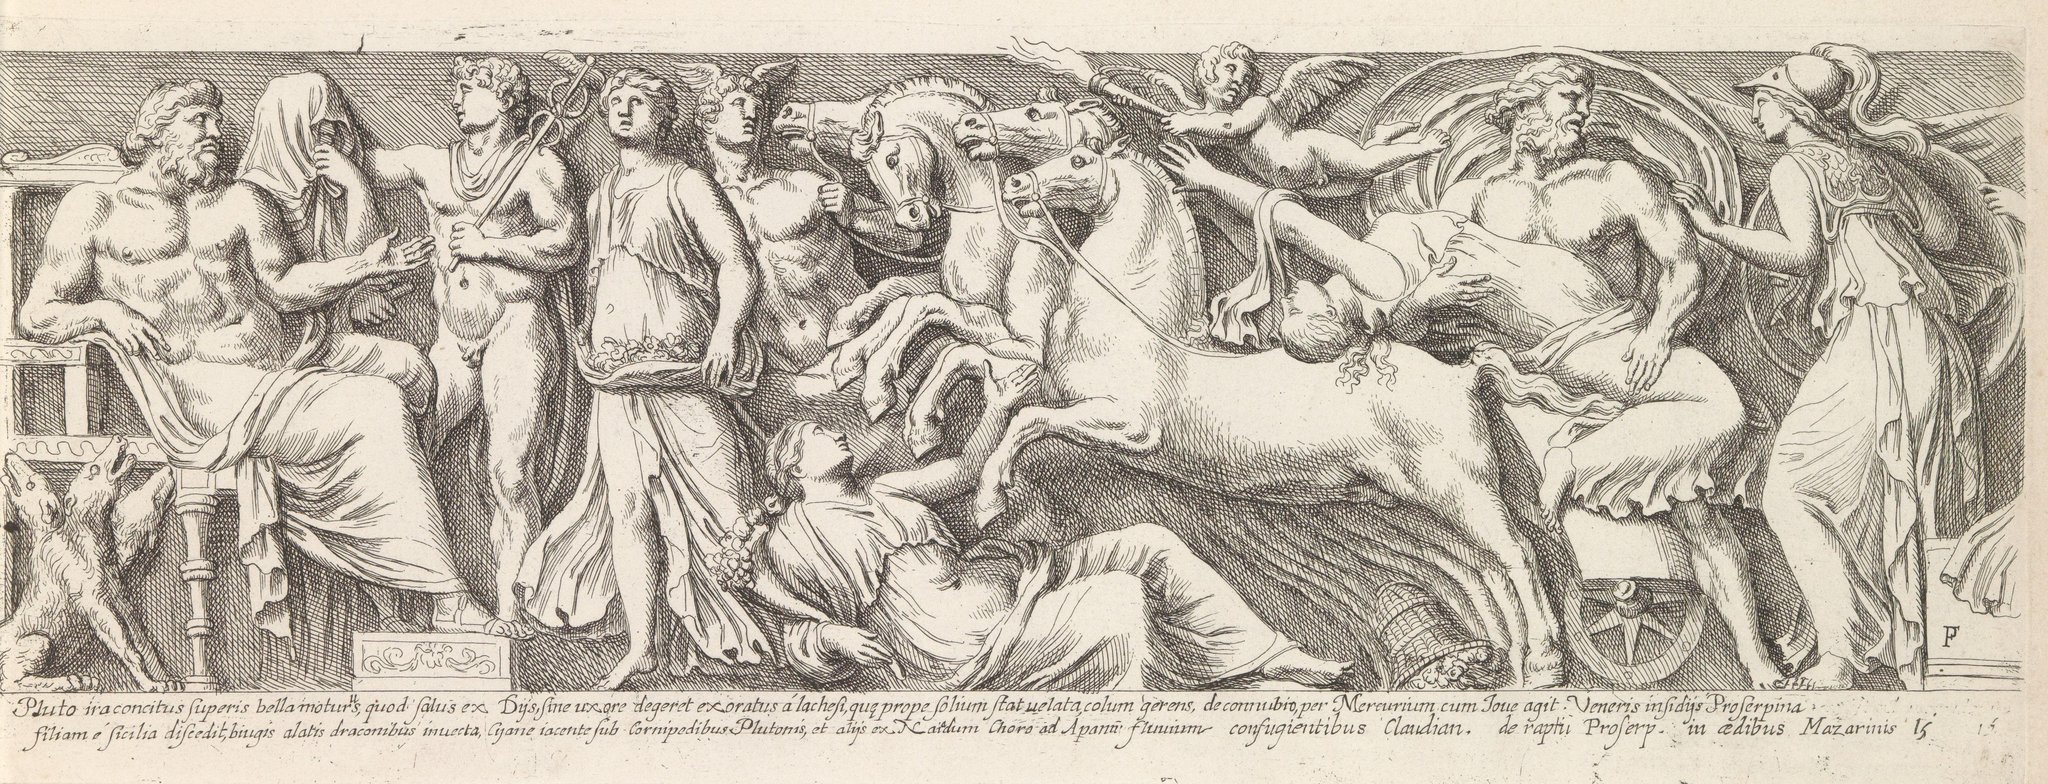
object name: album leaf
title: Reliëf met de roof van Proserpina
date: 1645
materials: paper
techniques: etching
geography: paris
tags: the rape of proserpina (by pluto in his chariot); possibly with diana and minerva trying to rescue her, piece of sculpture, reproduction of a piece of sculpture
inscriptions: number: ‘42’, inscription: ‘Ende lib. No. 5. fol. 105./ Ende lib. No. 5. fol. 78. 79.’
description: Reliëf met de roof van Proserpina door Pluto. Rechts Pluto die Proserpina meevoert op zijn wagen die wordt voortgetrokken door vier paarden. Voor de wagen een staande en een liggende nimf. Links staat Mercurius en zit Jupiter naast de Cerberus. Tekst in het Latijn in ondermarge. Prent maakt deel uit van een album.